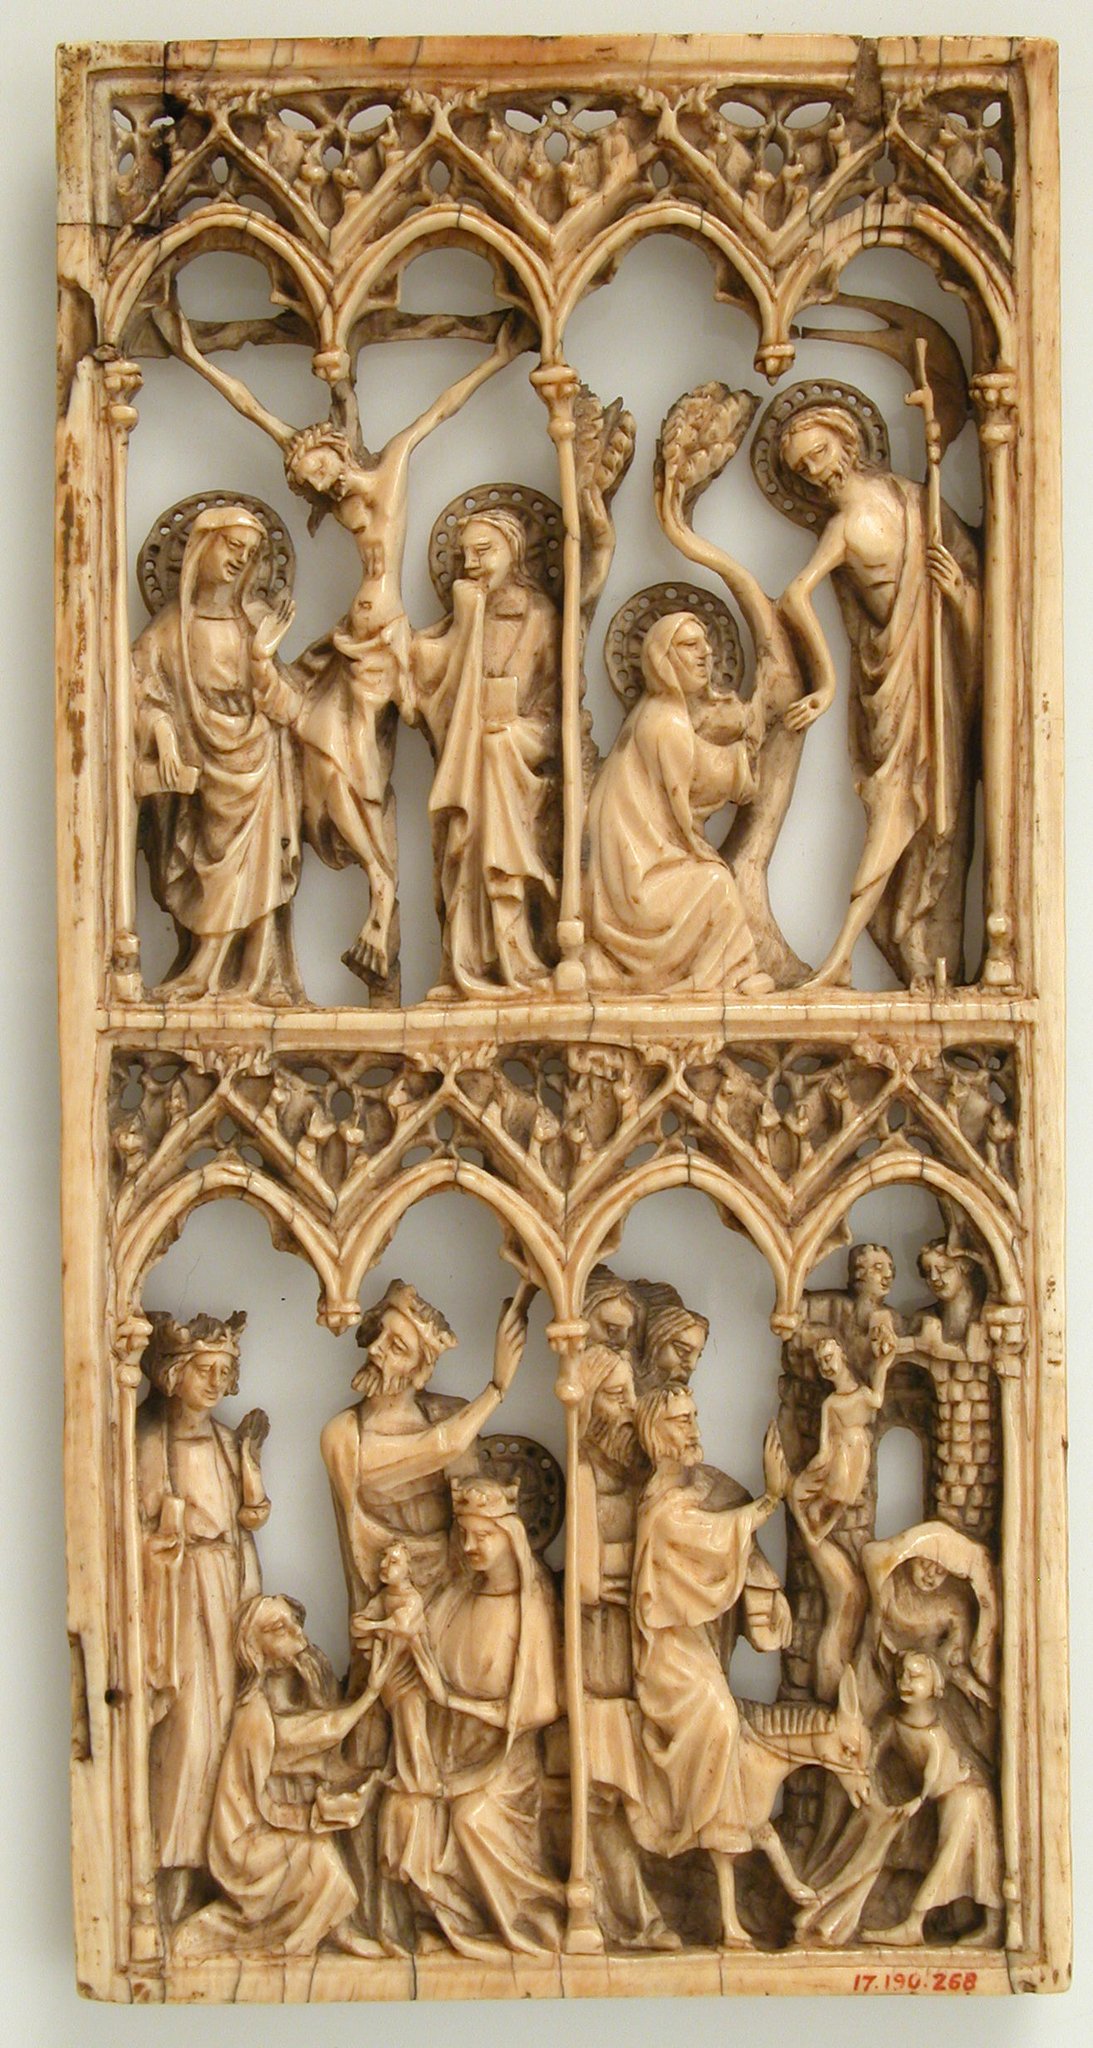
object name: diptych panel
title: Panel from a Diptych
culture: french or european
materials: ivory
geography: france or western europe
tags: christ,madonna and child,nativity,saints